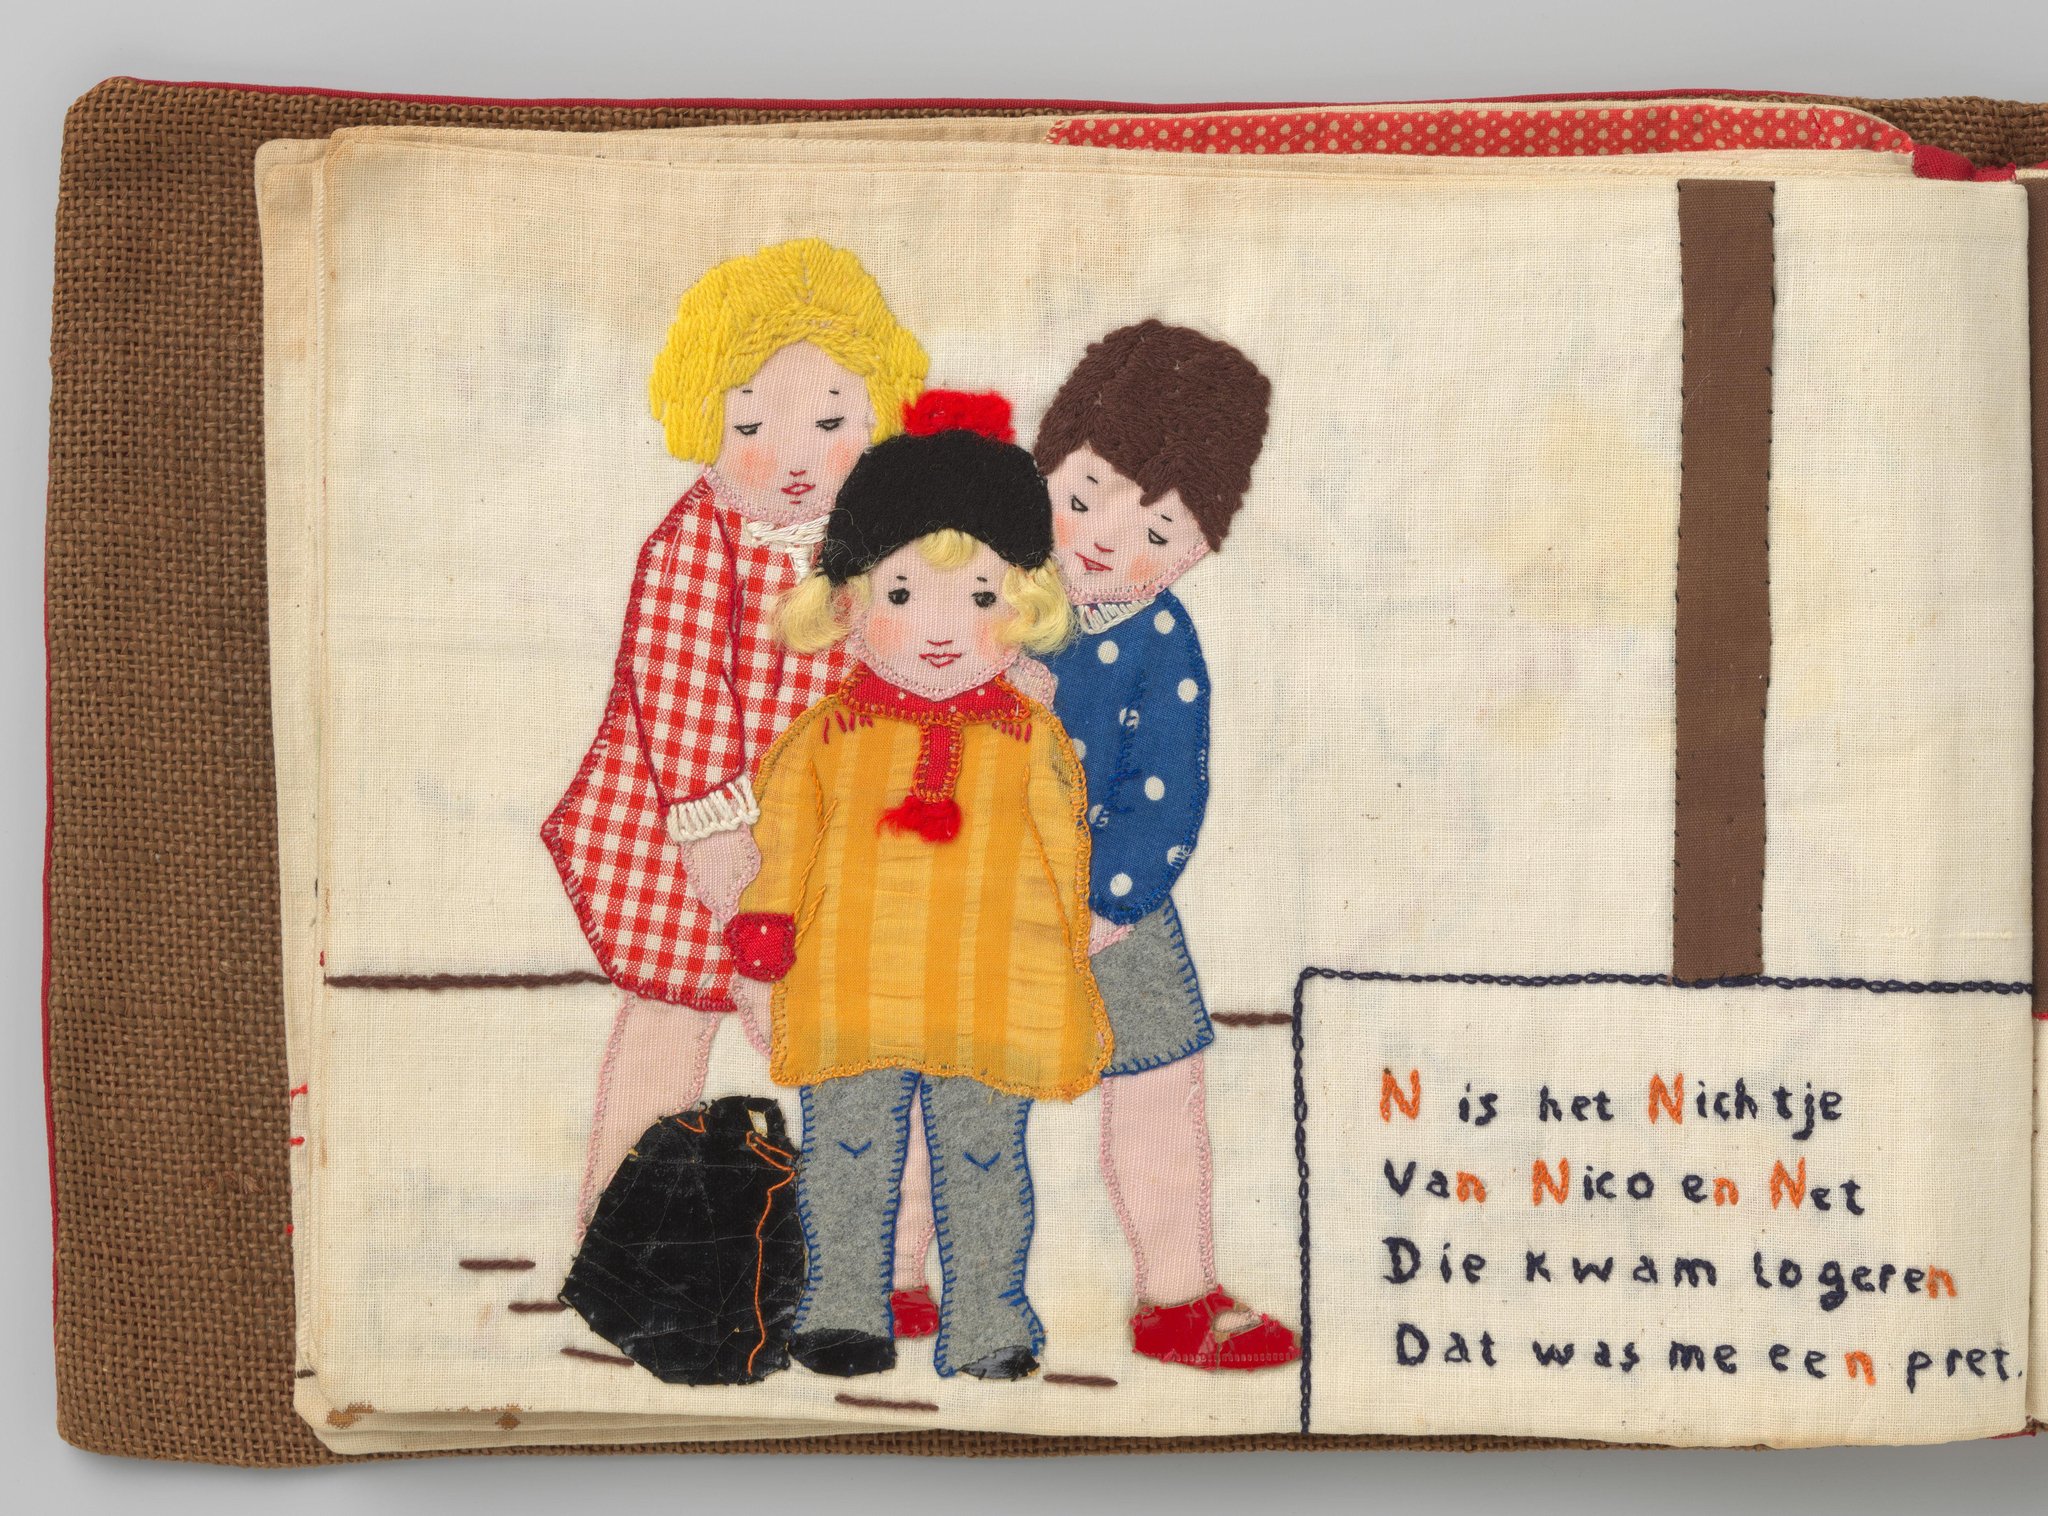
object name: blad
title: N is het Nichtje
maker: miesje geertruida maria petronella aalbersberg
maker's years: 1915-1997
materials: cotton, textile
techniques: appliqué, embroidered, stitch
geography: brastagi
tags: reading, book in which illustrations are essential, letters, alphabet, script, internment camp, nursery school (+ teaching aids), (other forms of) needlework, e.g.: crocheting, knitting, embroidering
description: In het geheim gemaakt kinderboek in textiel vrij naar A is een Aapje van Rie Cramer. Het werd gezamenlijk gemaakt door de vrouwelijke gevangenen van het Japanse interneringskamp Brastagi, een oude plantage in Noord-Sumatra 60 kilometer ten zuiden van Medan aan de weg naar het Toba-meer, tijdens de Tweede Wereldoorlog ter gelegenheid van de vijfde verjaardag van Pem Hagers, de dochter van Miesje Hagers-Aalbersberg die de ontwerptekeningen en sjablonen had gemaakt.